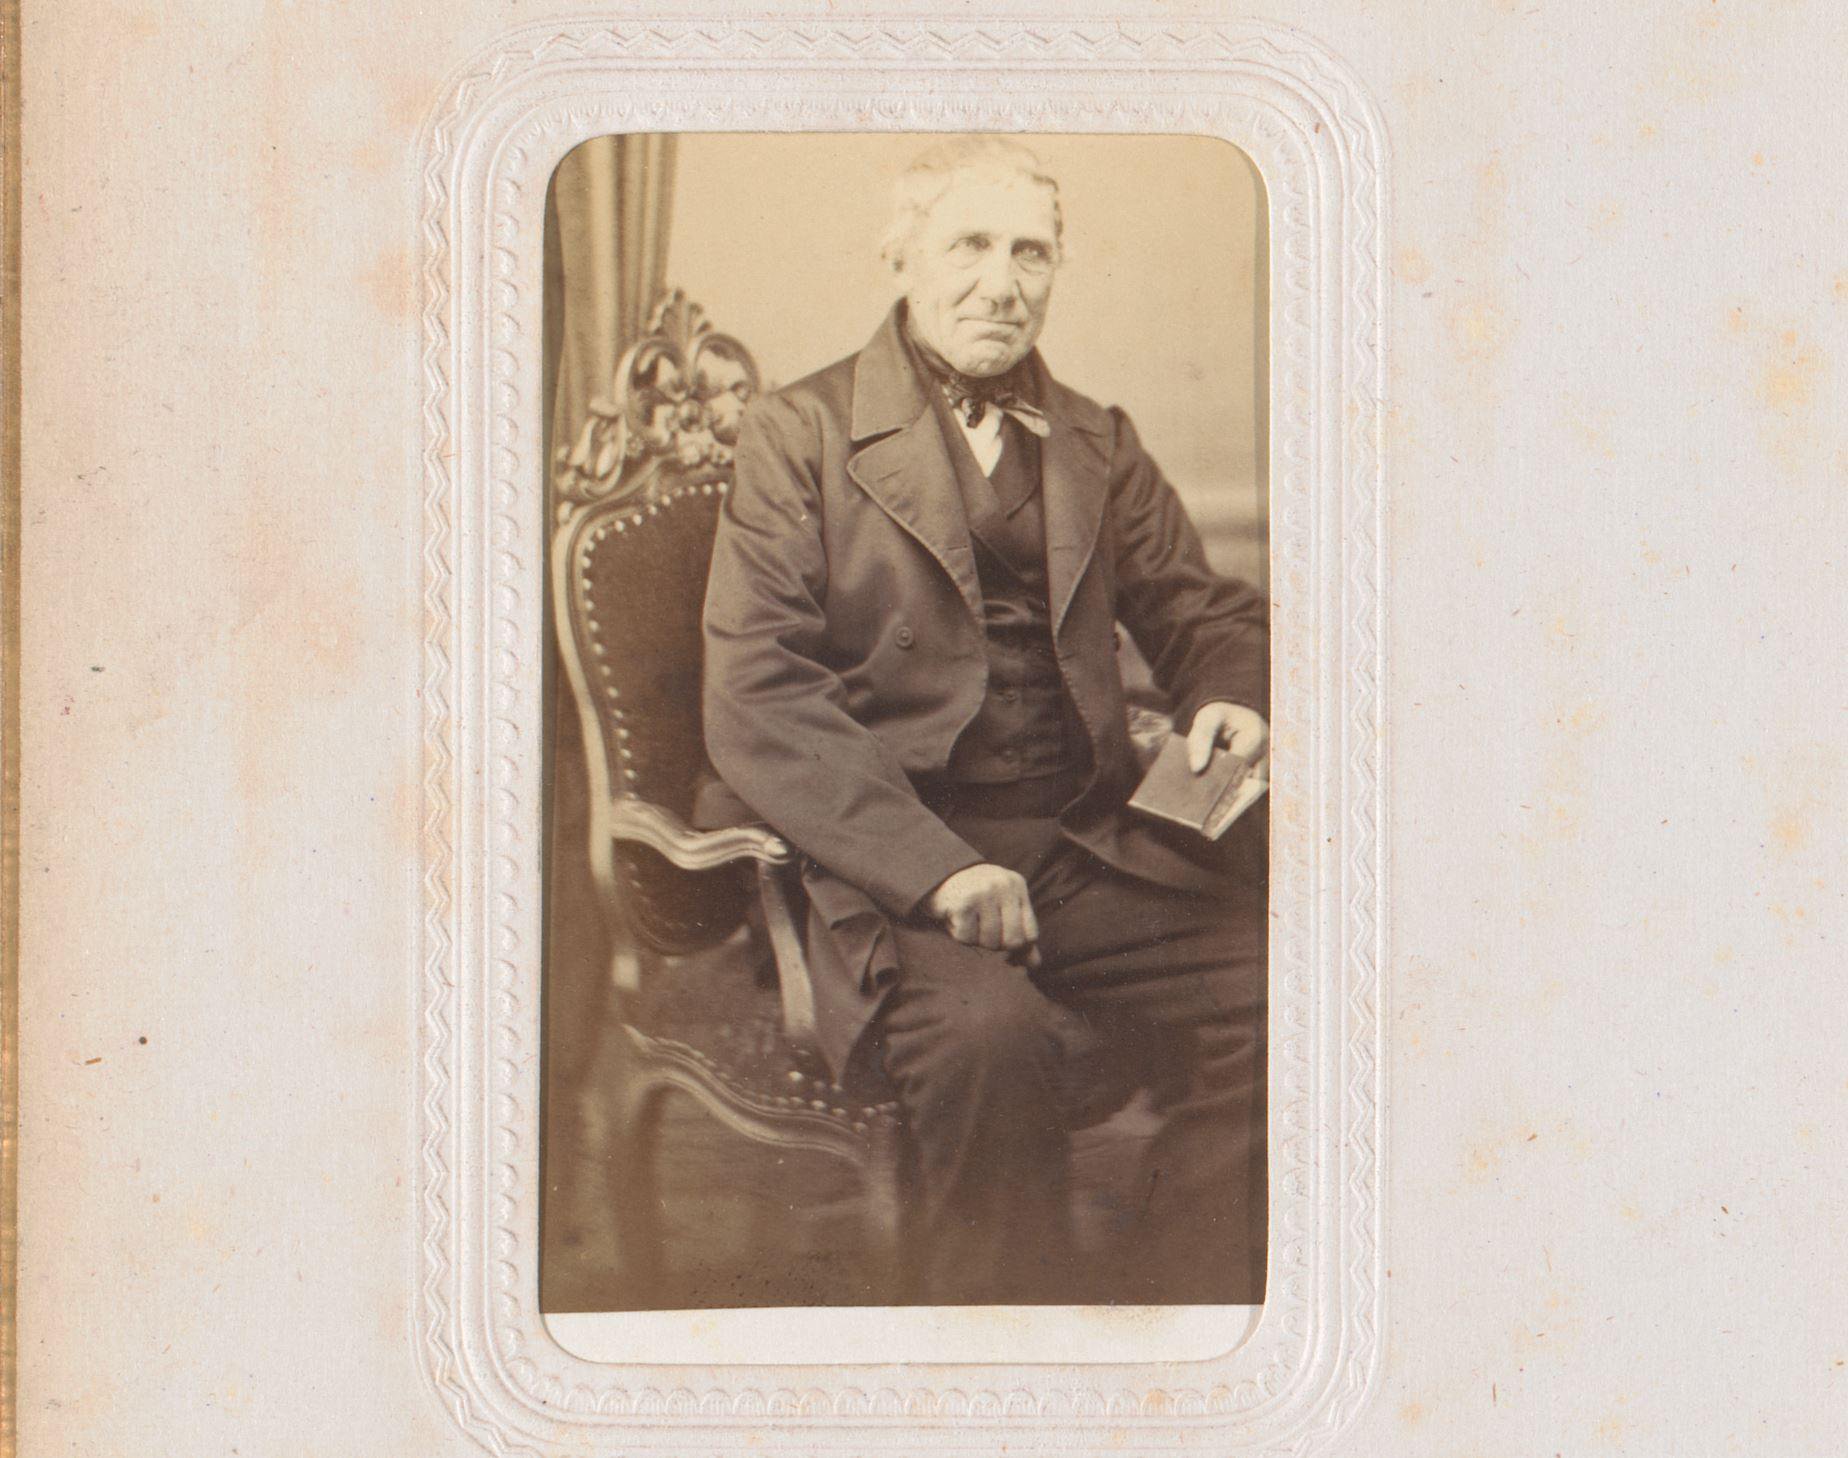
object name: album leaf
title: Portret van een zittende man met boek in de hand, aangeduid als J. Swets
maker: kornelis willem schorteldoek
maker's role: boekbinder, fotograaf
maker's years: 1800-1885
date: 1855-1885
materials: cardboard, photographic support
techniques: albumen print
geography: gorinchem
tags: sitting figure, historical persons, book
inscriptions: name: ‘J. Swets’, inscription: ‘SCHORTELDOEK/ PHOTOGRAAF/ GORINCHEM/ Groote Markt’